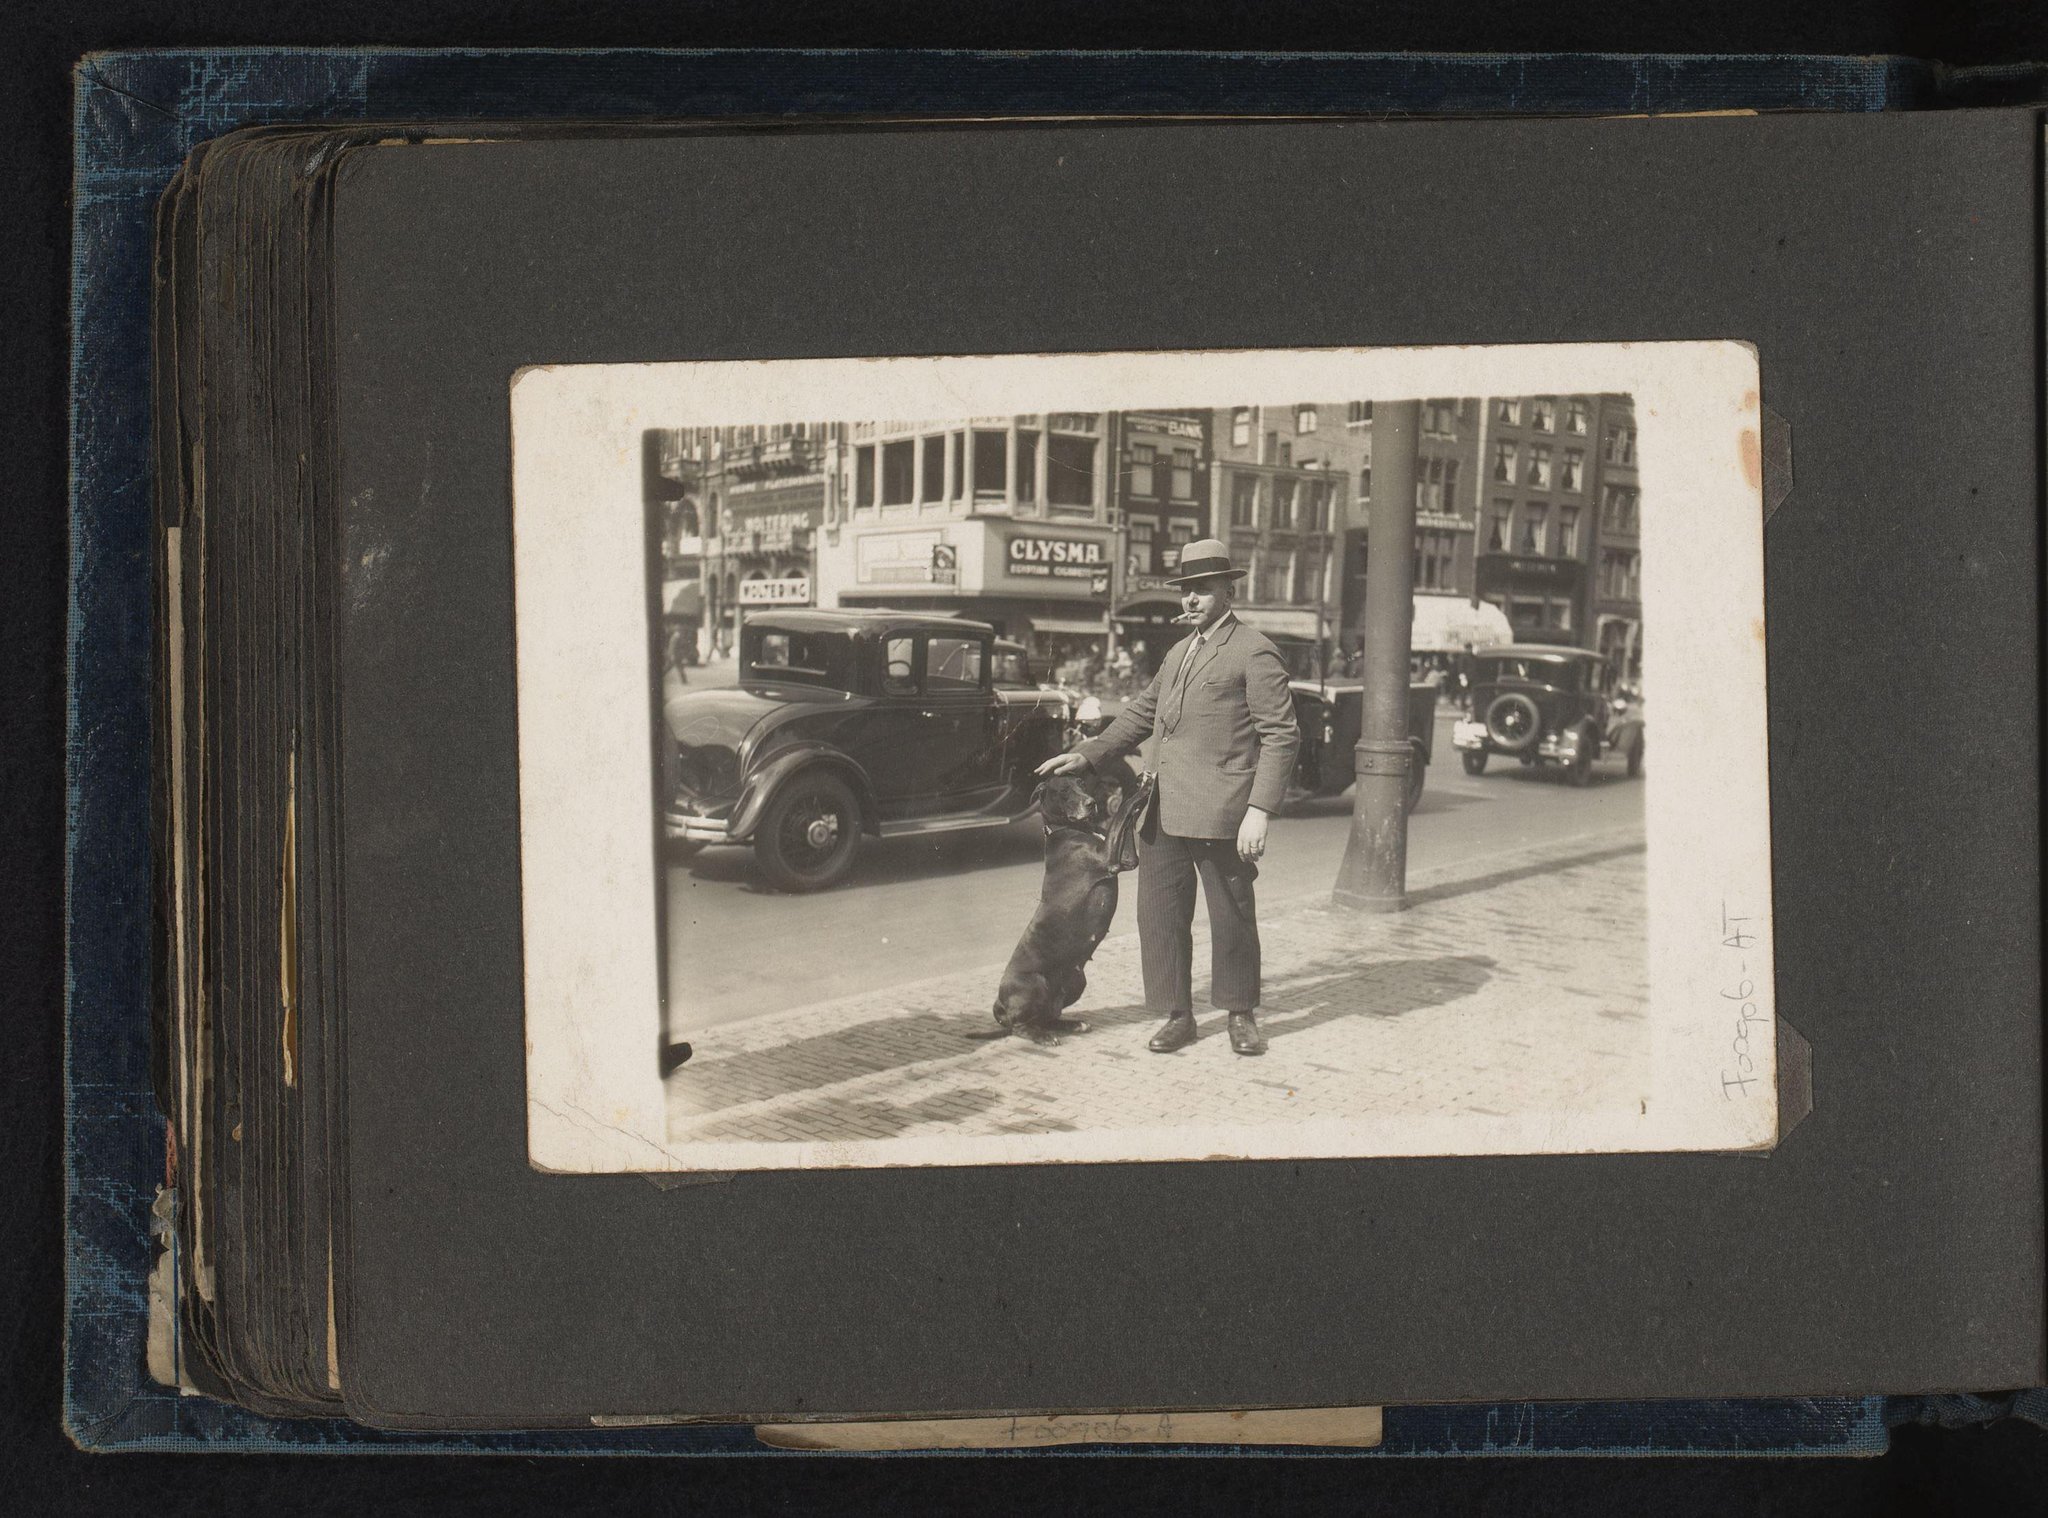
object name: photograph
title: Portret van de poppendokter met hond op straat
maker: Anonymous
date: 1930-1940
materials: photographic support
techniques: gelatin silver print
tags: adult man, historical persons, street, dog